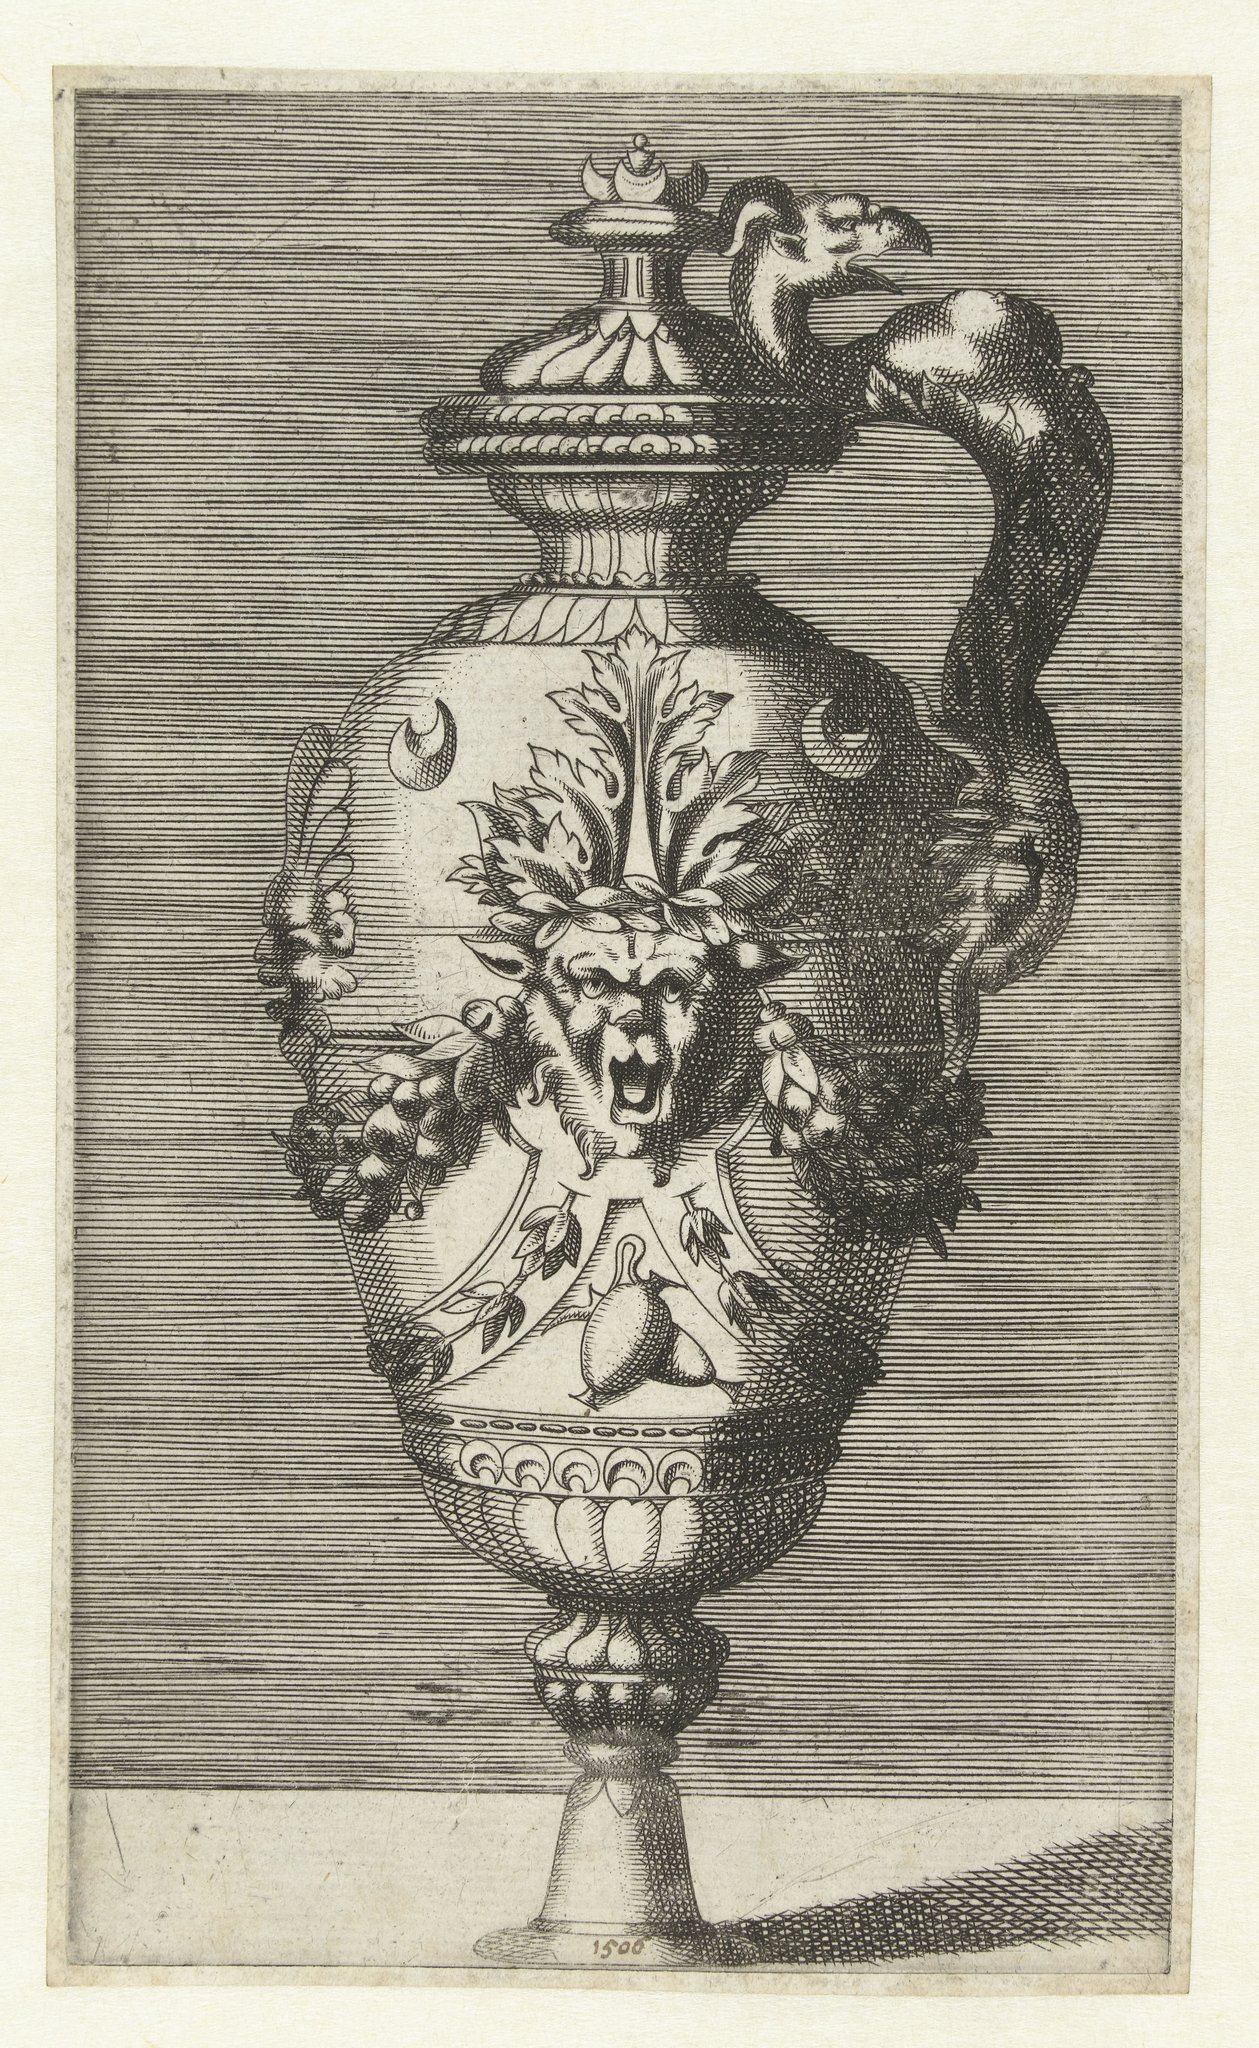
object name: ornament print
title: Kan met een deksel en een oor, gevormd door een soort harpij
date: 1551-1580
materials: paper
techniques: engraving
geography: france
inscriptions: inscription: ‘1506’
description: De buik van de kan is gedecoreerd met een mascaron met een grote toef bladeren op zijn hoofd. Horizontaal gearceerde achtergrond. Blad uit serie van 12 bladen.